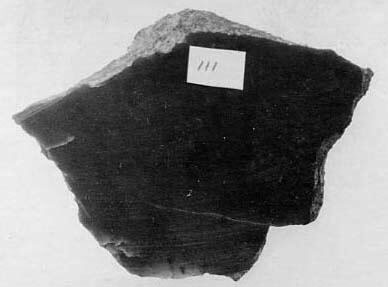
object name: fragment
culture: russian, siberia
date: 1902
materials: jade